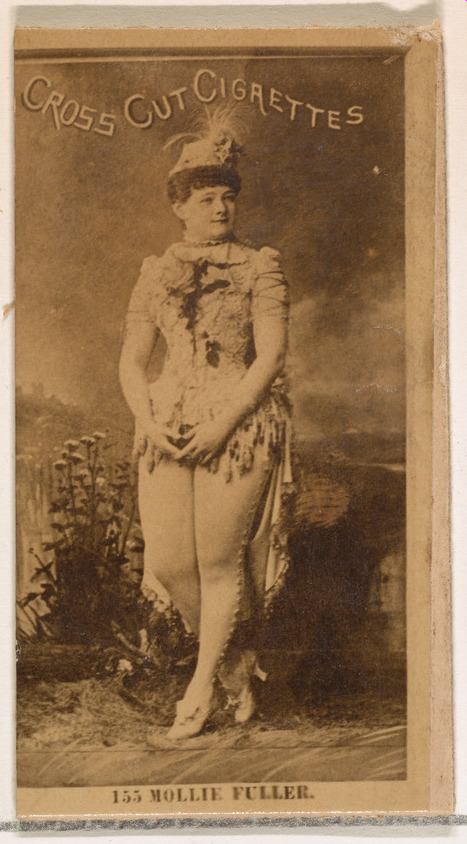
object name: print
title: Card Number 155, Miss Fuller, from the Actors and Actresses series (N145-2) issued by Duke Sons & Co. to promote Cross Cut Cigarettes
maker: w. duke, sons & co.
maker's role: publisher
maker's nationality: american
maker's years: 1870-1920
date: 1880-1889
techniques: albumen silver print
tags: portraits,women,actresses